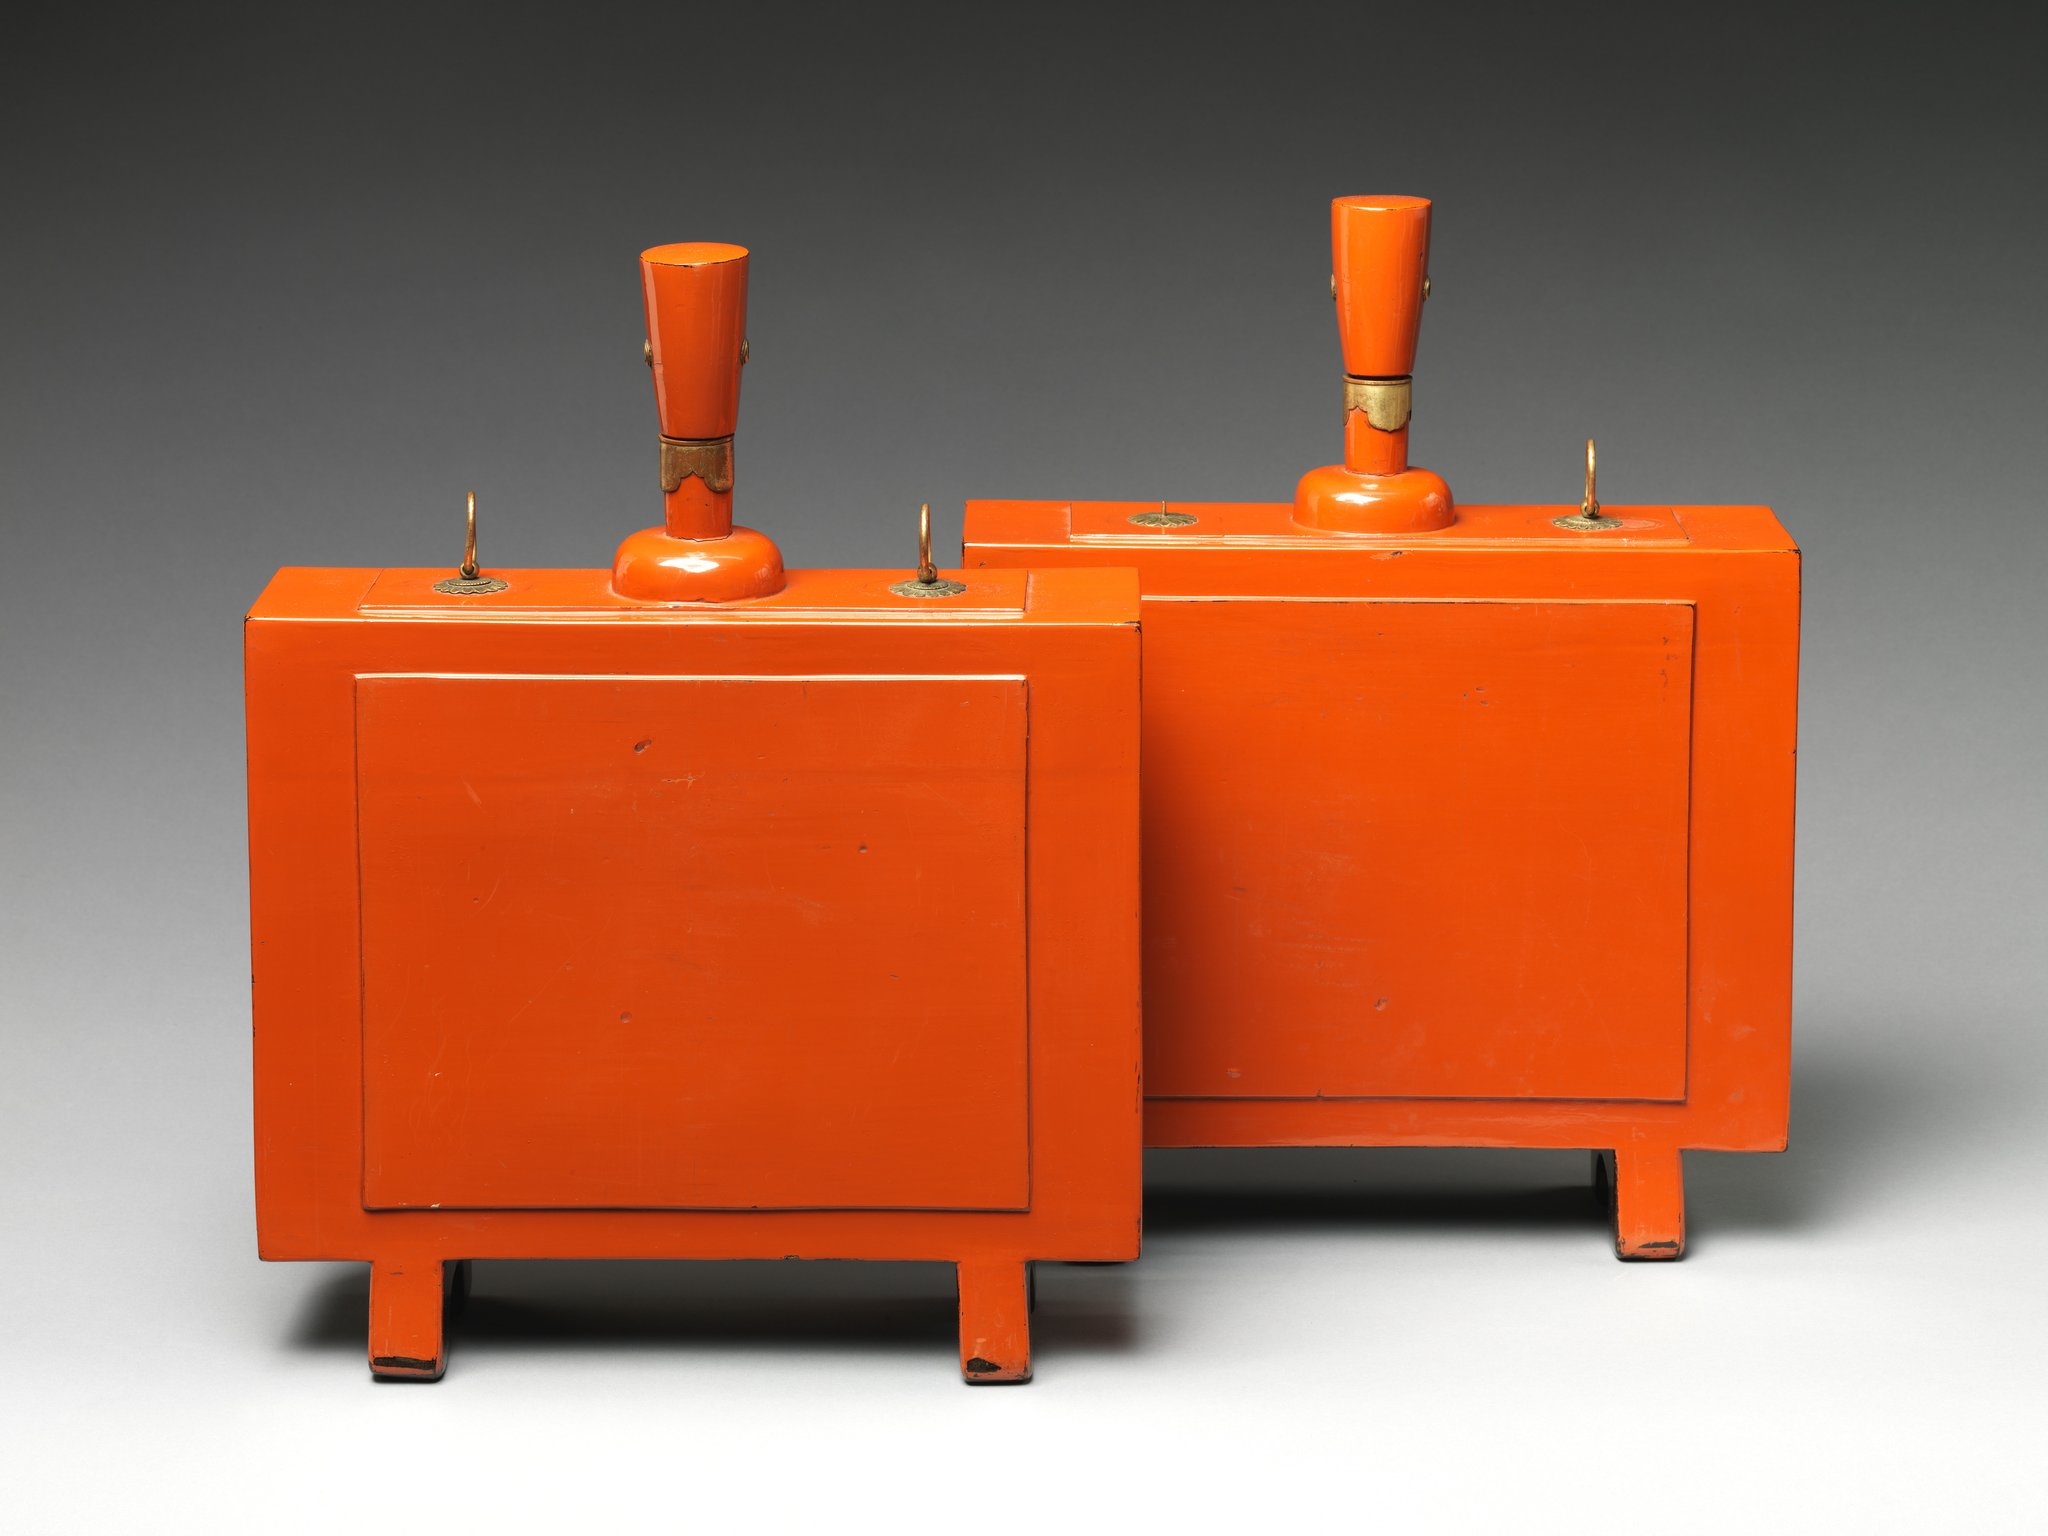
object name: sake casket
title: Pair of Sake Caskets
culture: japanese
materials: lacquer, wood